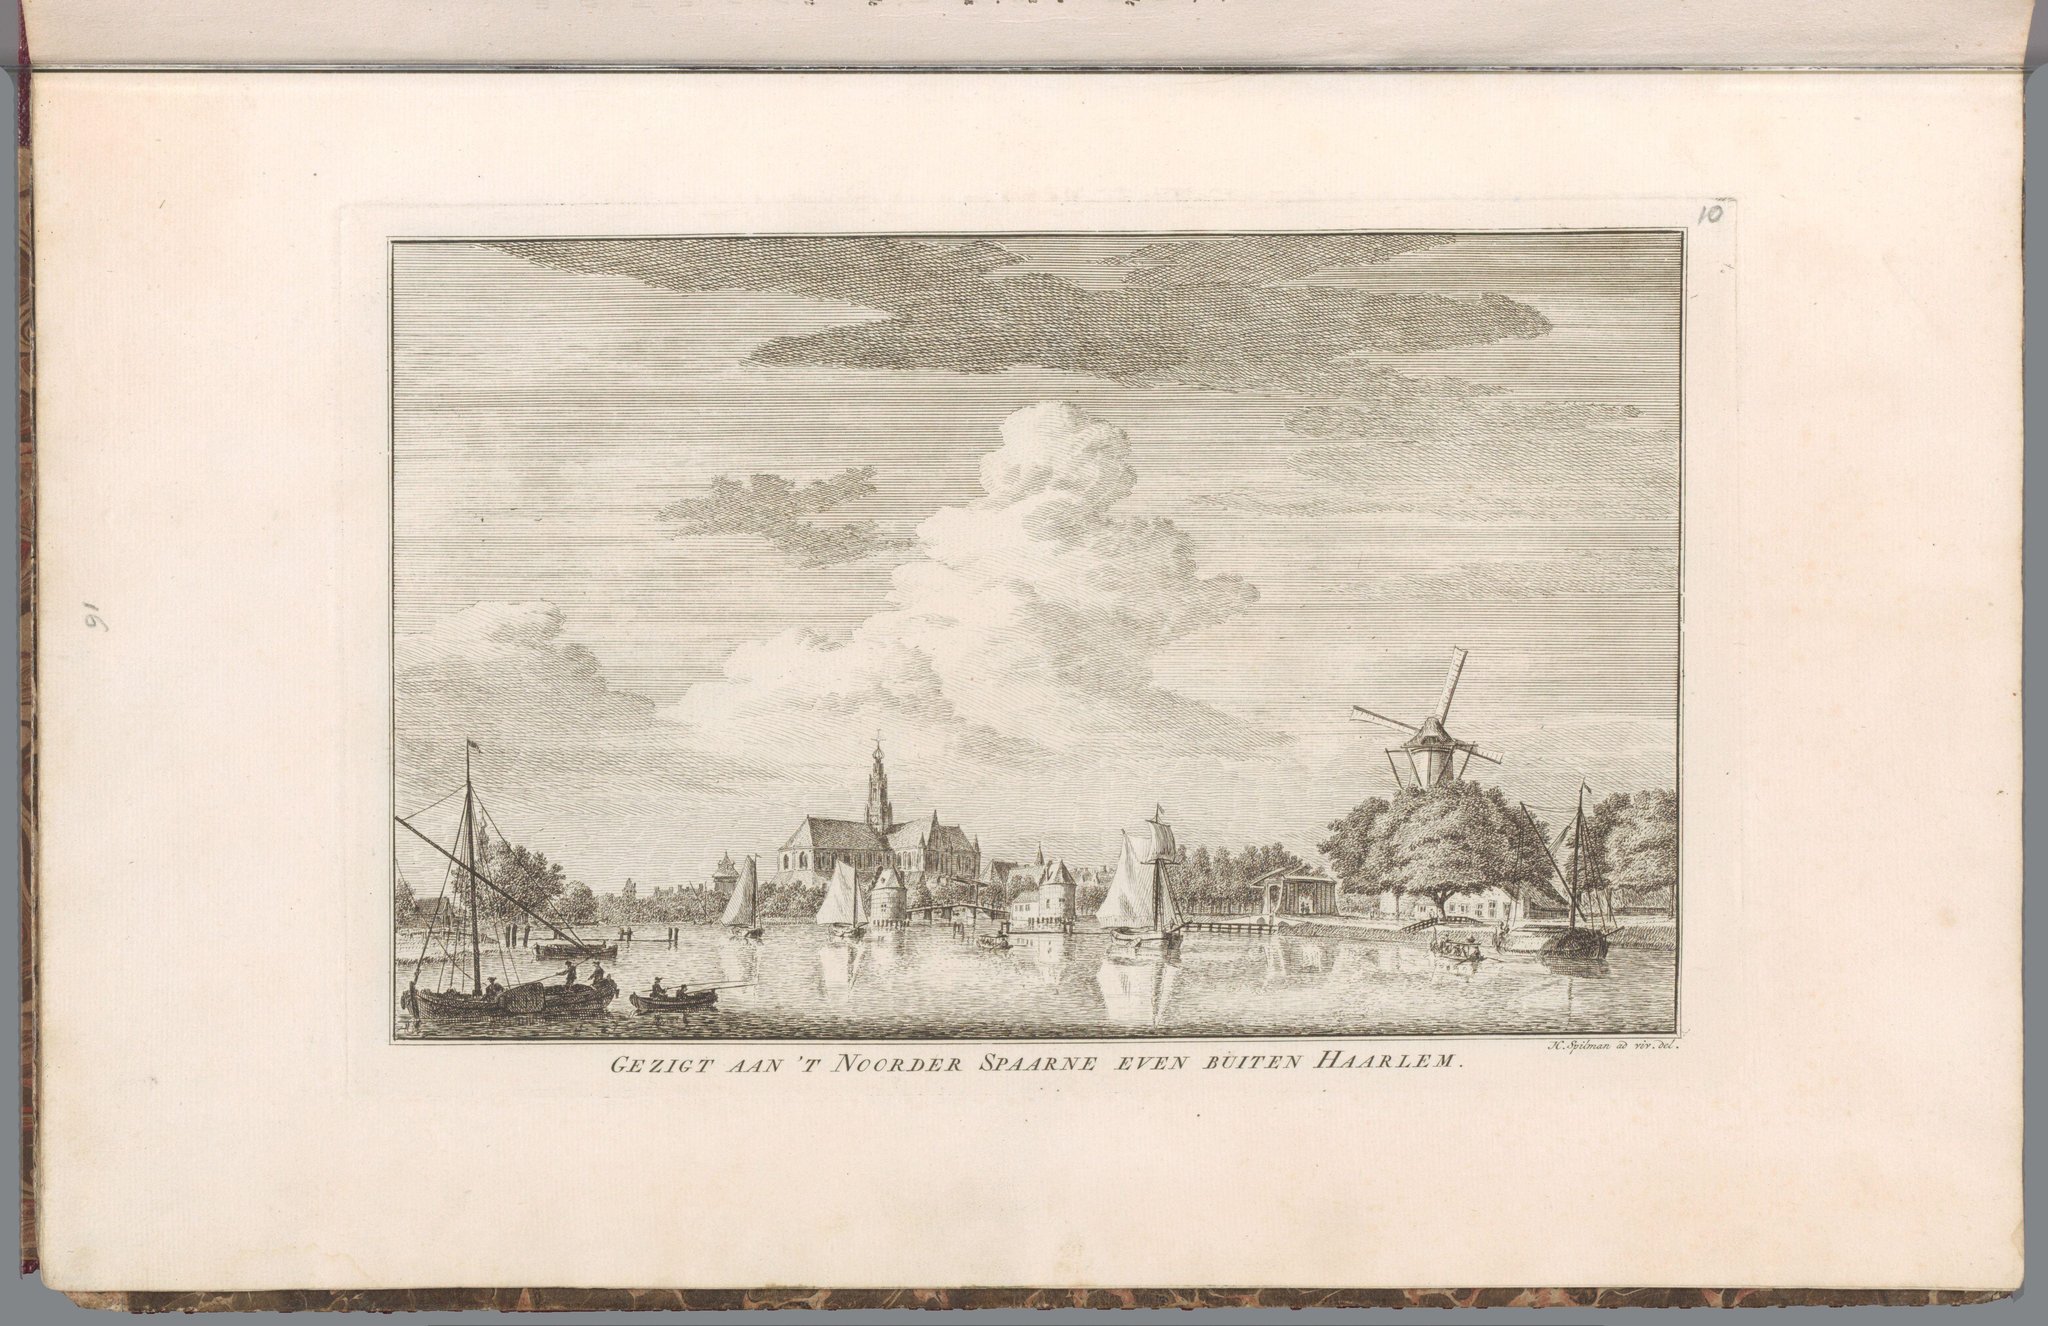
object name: print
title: Gezigt aan 't Noorder Spaarne even buiten Haarlem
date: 1762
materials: paper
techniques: etching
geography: haarlem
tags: city-view in general; 'veduta', river, haarlem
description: Gezicht op het Noorder Spaarne met op de achtergrond de stad Haarlem. Op het water enkele zeilschepen. Deze prent maakt deel uit van een album.